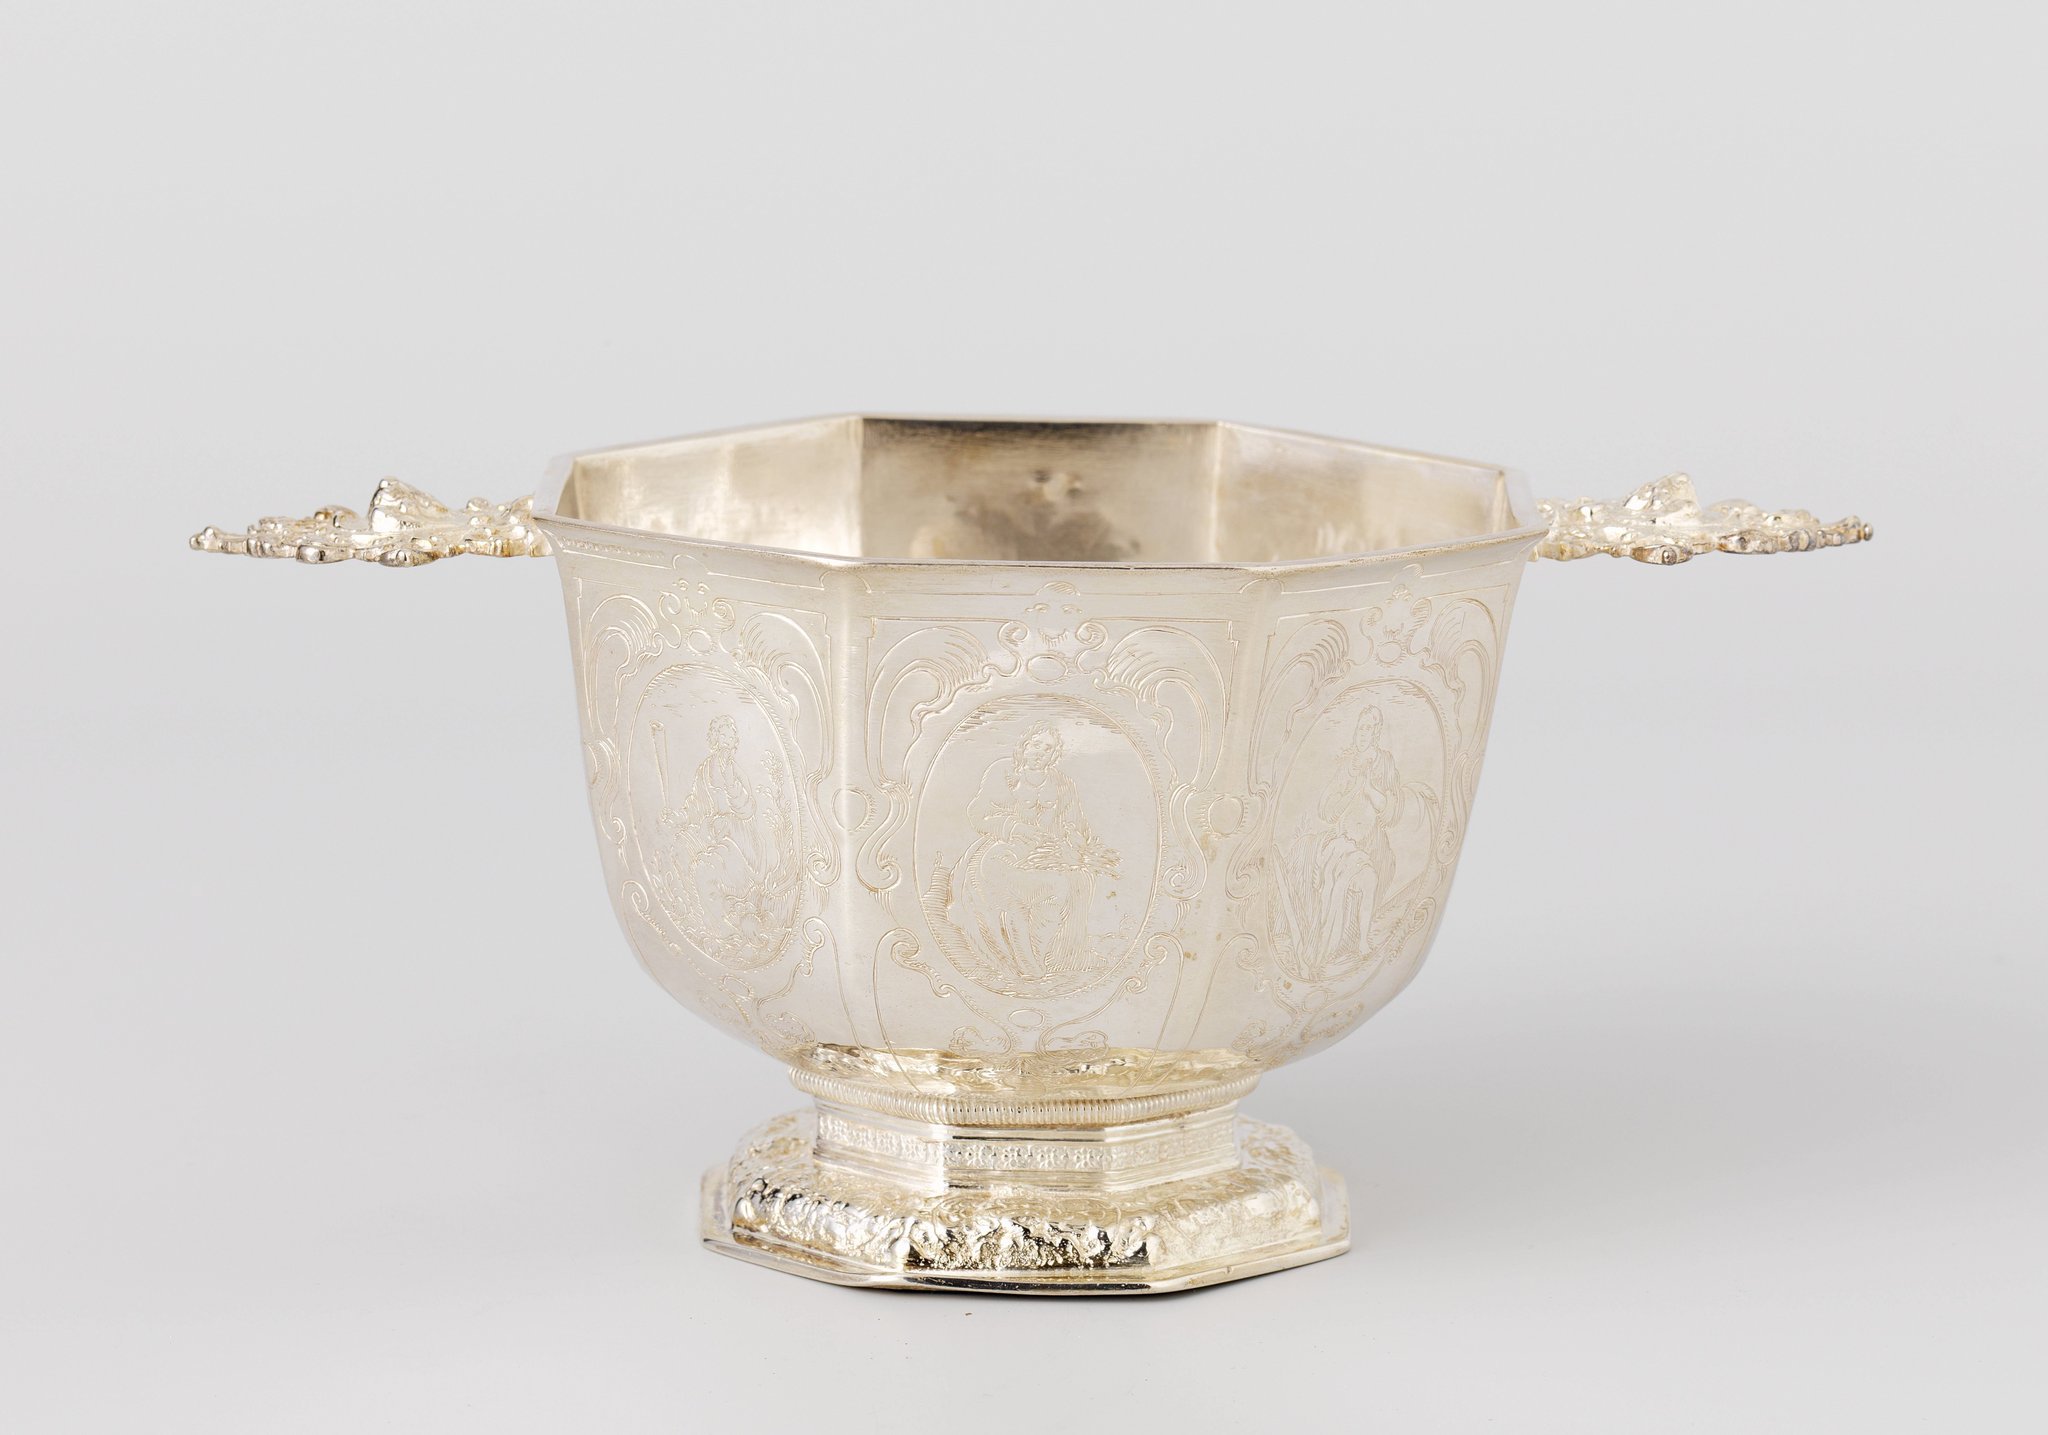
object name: brandy bowl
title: Brandewijnkom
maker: pieter jacobs clinckhamer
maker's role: silversmith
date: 1672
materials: silver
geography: harlingen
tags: adult woman, ornament ~ cartouche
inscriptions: mark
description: Brandy bowl. Silver. Harlingen, 1672, by Pieter Jacobs Clinckhamer.